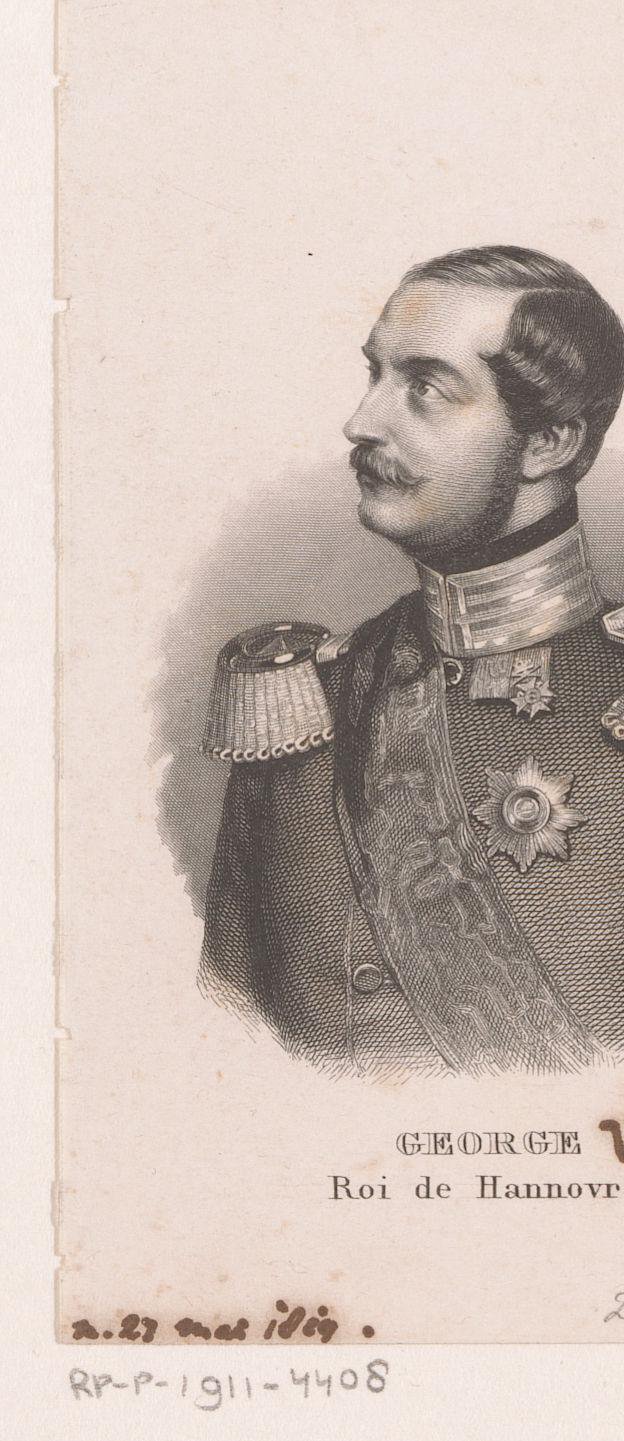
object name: print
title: Portret van Georg von Mecklenburg-Strelitz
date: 1808-1868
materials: paper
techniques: engraving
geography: nuremberg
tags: historical persons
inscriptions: collector's mark: Lugt 2228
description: Vermoedelijk afkomstig uit: Almanach de Gotha.